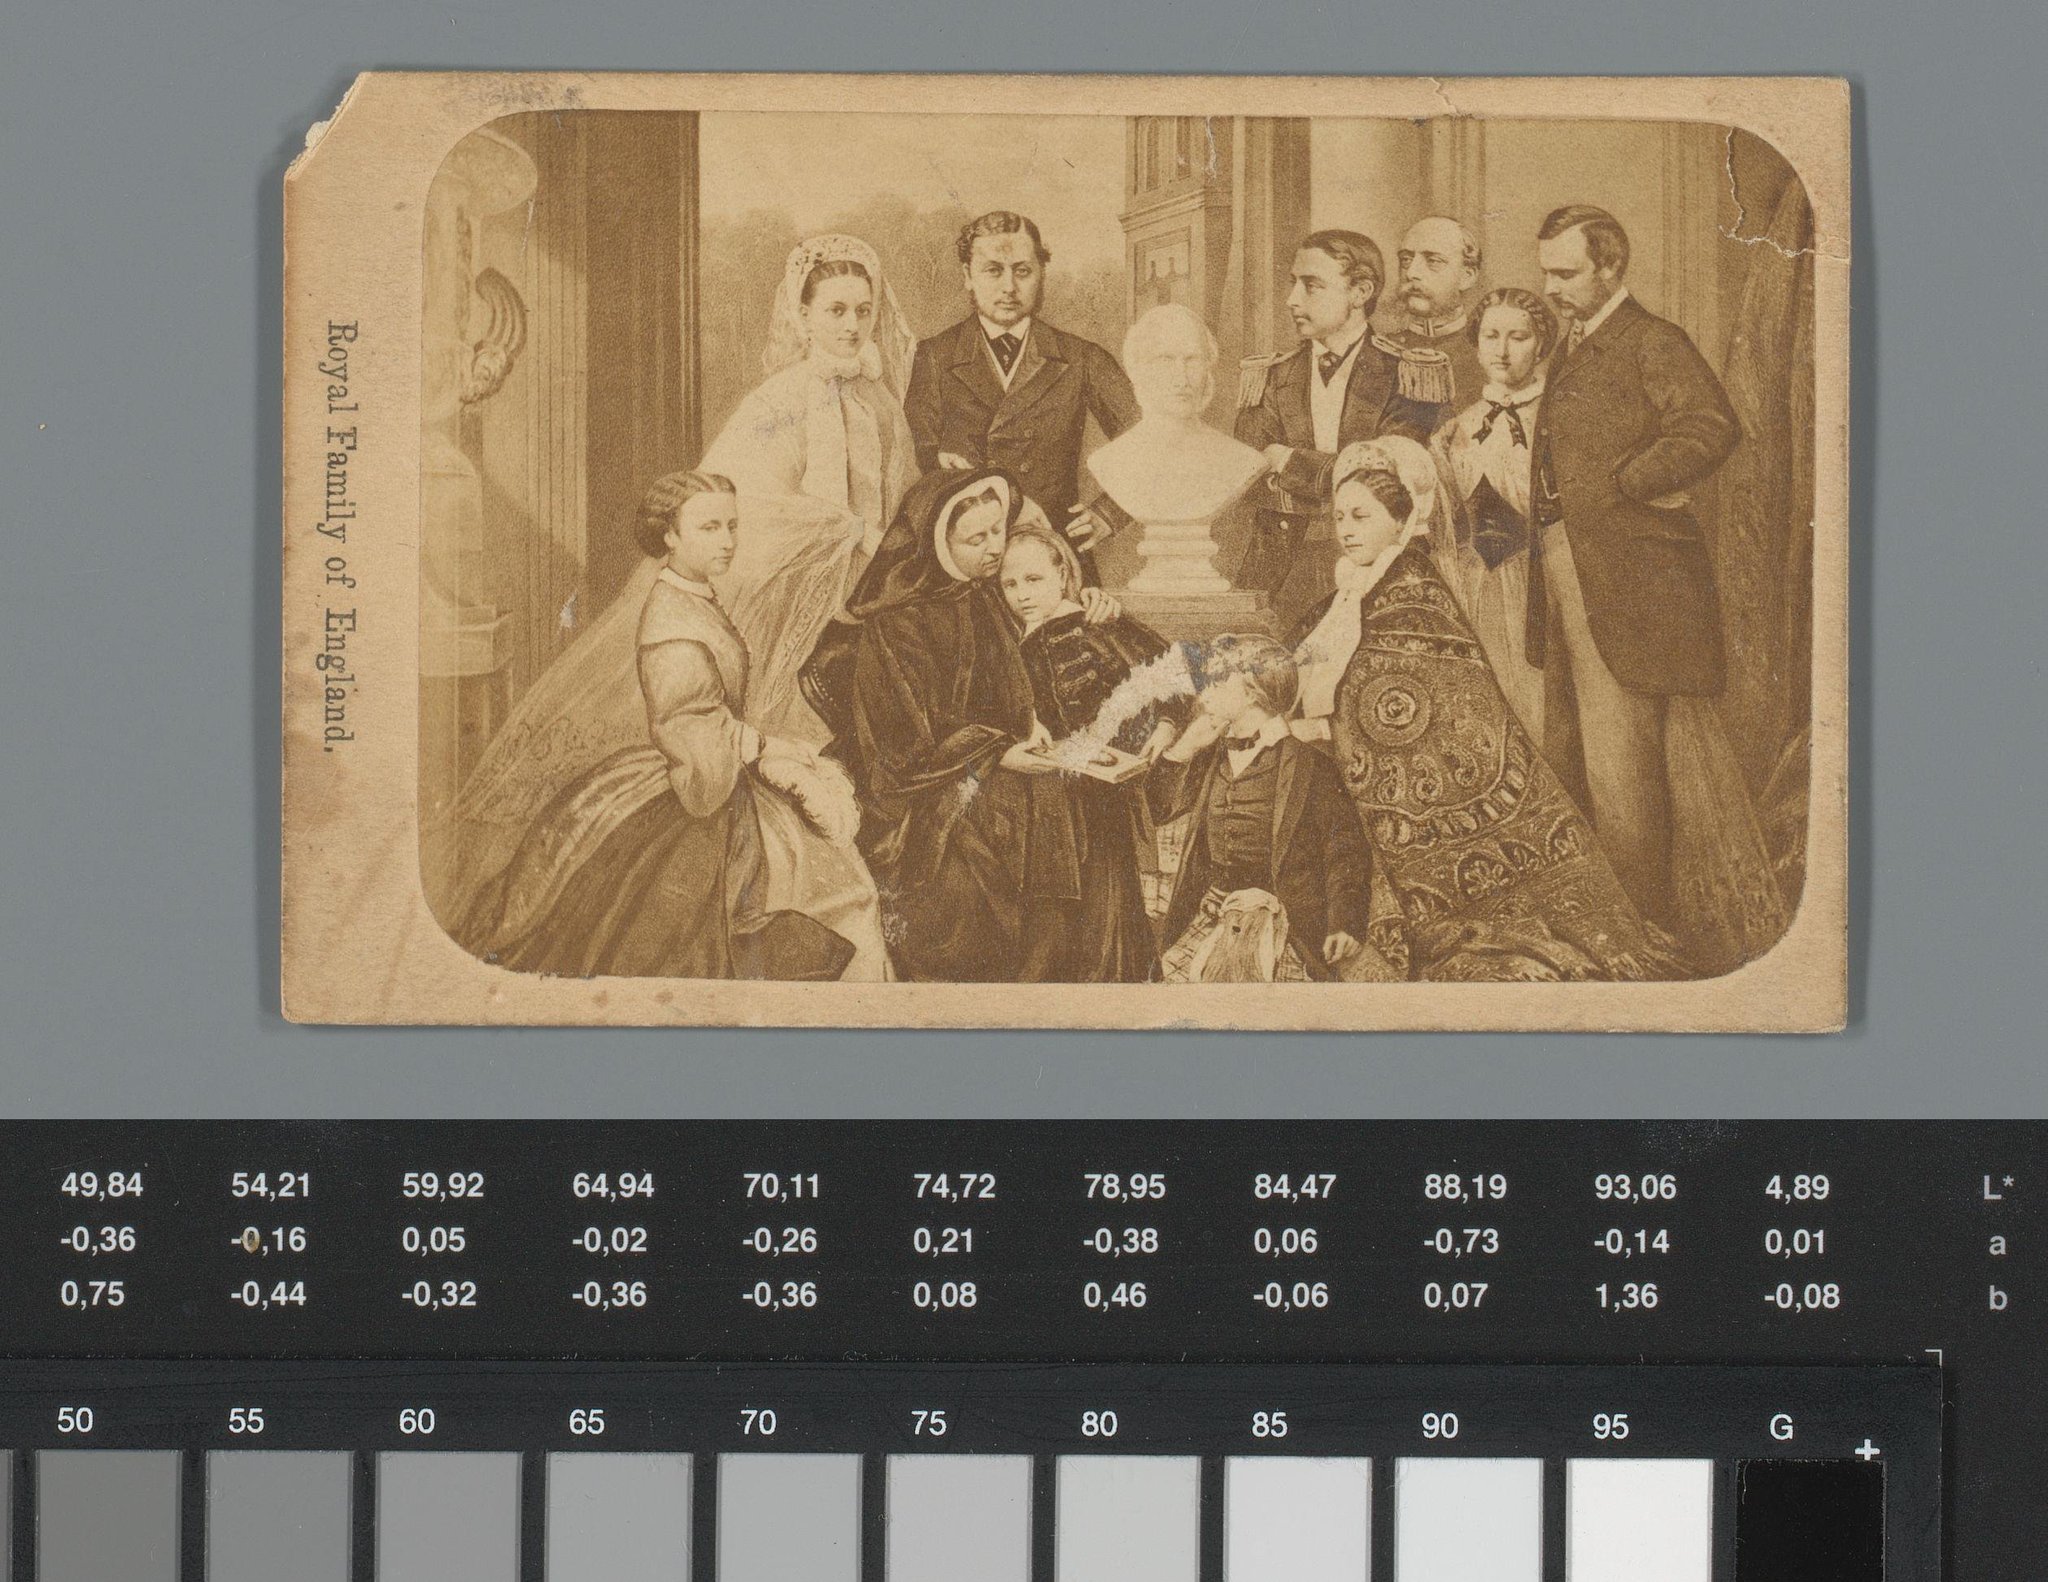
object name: reproduction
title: Fotoreproductie van een prent van de Britse Koninklijke familie met reclame voor warenhuis City of Paris, Chicago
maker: Anonymous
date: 1861-1915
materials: cardboard, photographic support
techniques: albumen print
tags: victoria (koningin van het verenigd koninkrijk en keizerin van india), vienna, politician, london, louise van saksen-coburg en gotha (hertogin van argyll), advertising, family of a ruler, and court, historical persons - bb - woman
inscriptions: inscription: ‘(...)’